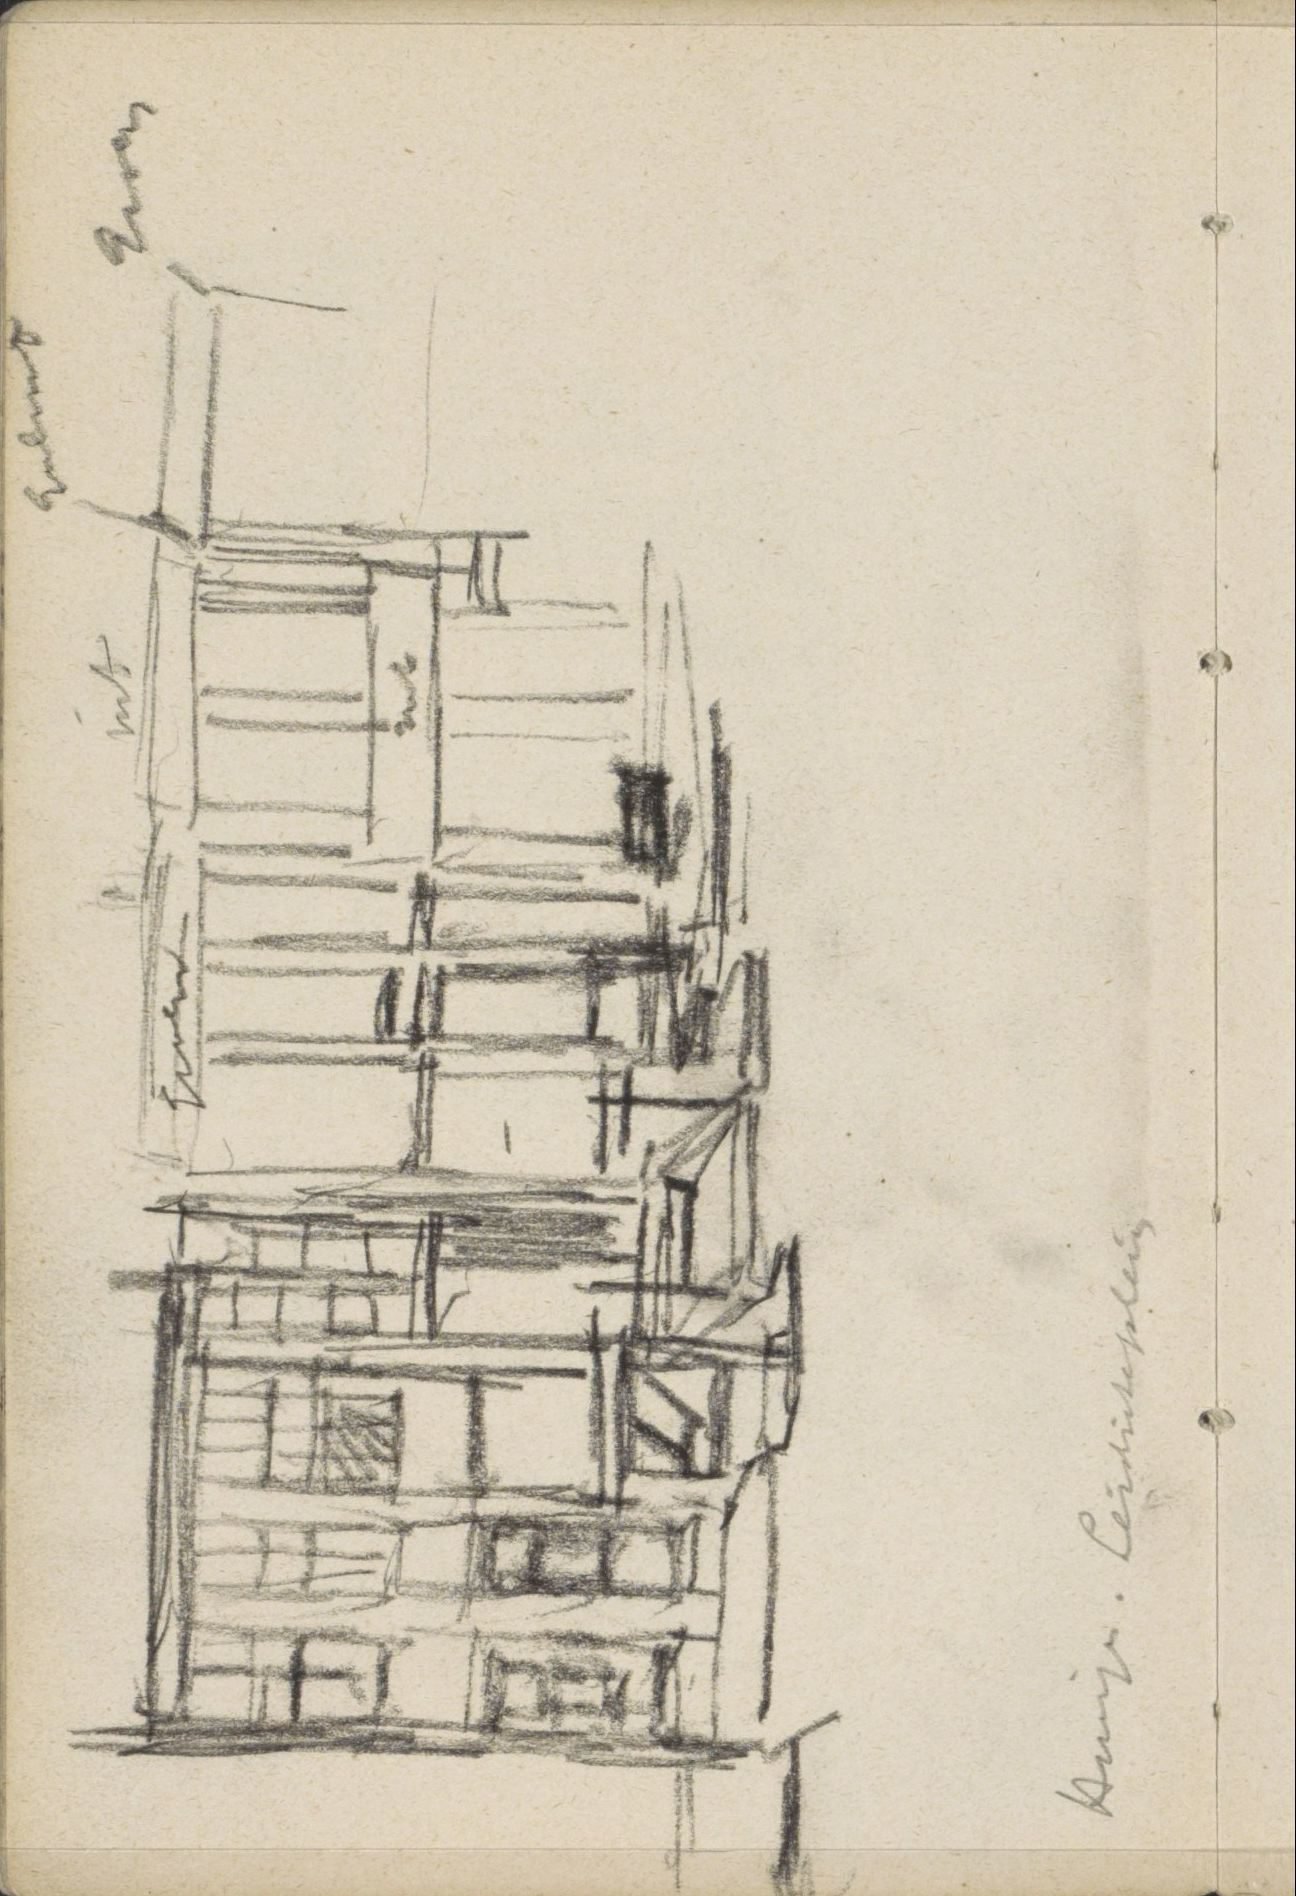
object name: sketchbook leaf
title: Gezicht op huizen aan het Leidseplein te Amsterdam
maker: george hendrik breitner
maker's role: draughtsman, painter, print maker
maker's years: 1857-1923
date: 1907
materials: chalk, paper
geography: amsterdam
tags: square, place, circus, etc., urban housing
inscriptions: annotation: ‘Huizen Leidscheplein’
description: Gezicht op huizen aan het Leidseplein te Amsterdam. Pagina 7 uit een schetsboek met 46 bladen vervaardigd in Amsterdam, Rotterdam en Haarlem.